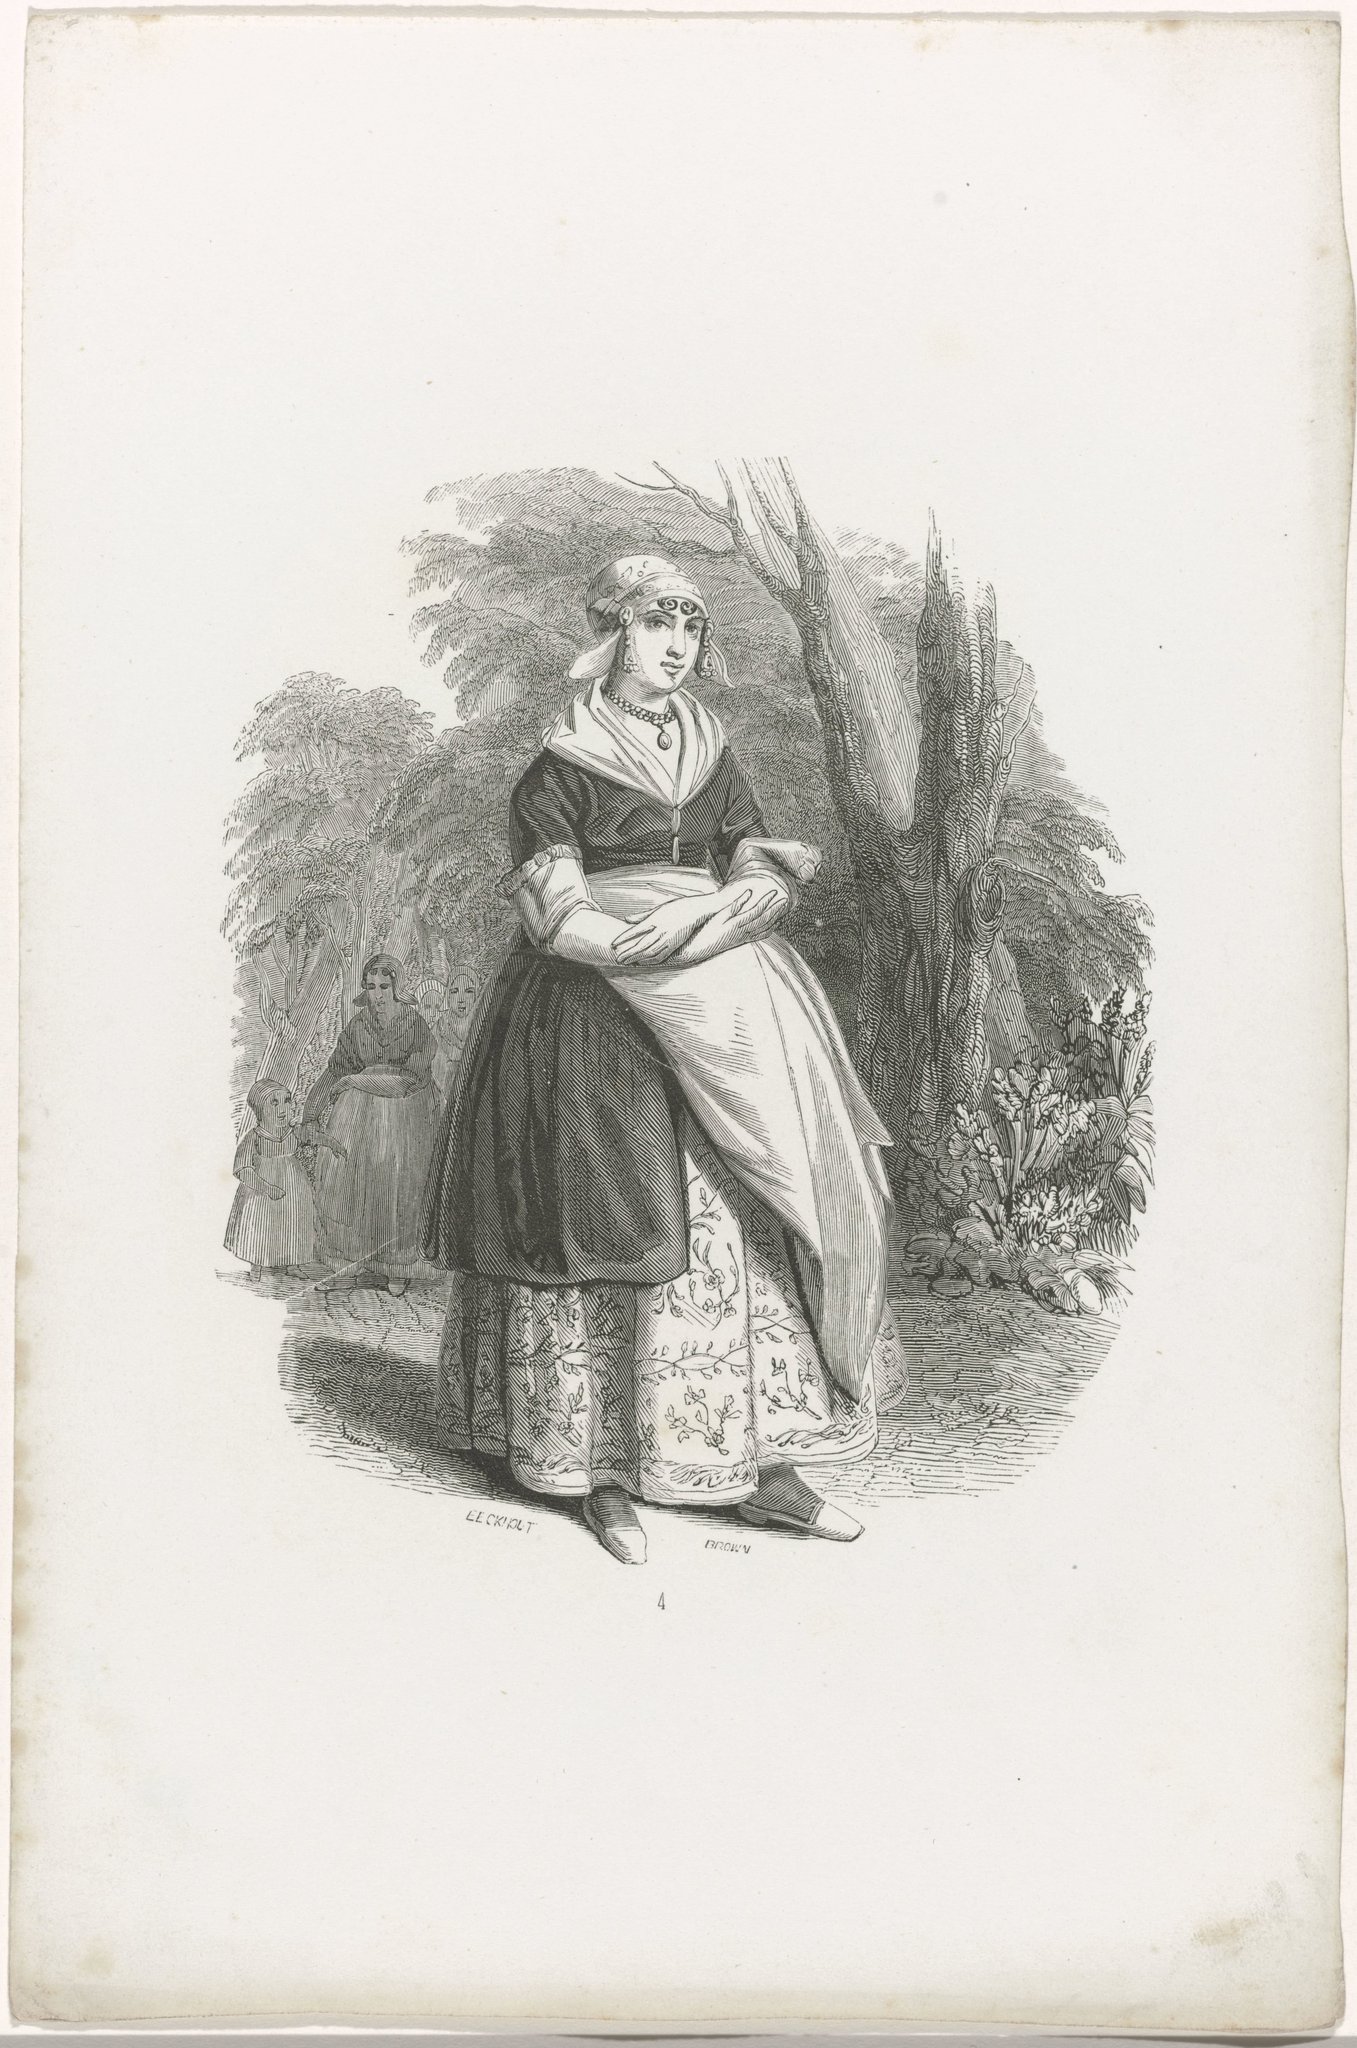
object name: costume print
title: De Scheveningse visvrouw, 1840-1841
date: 1840-1841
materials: paper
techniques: engraving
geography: netherlands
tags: professional clothes, street-trader - bb - women engaged in trade and commerce, merchant, salesman - bb - women engaged in trade and commerce, folk costume, regional costume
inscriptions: collector's mark: Lugt 2228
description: Gebruikt als illustratie in: De Nederlanden : karakterschetsen, kleederdrachten, houding en voorkomen van verschillende standen : tekst van de meest geachte schrijvers : met gravuren van Henry Brown naar teekeningen van de voornaamste Nederlandsche kunstenaars. 's Gravenhage, 1841.